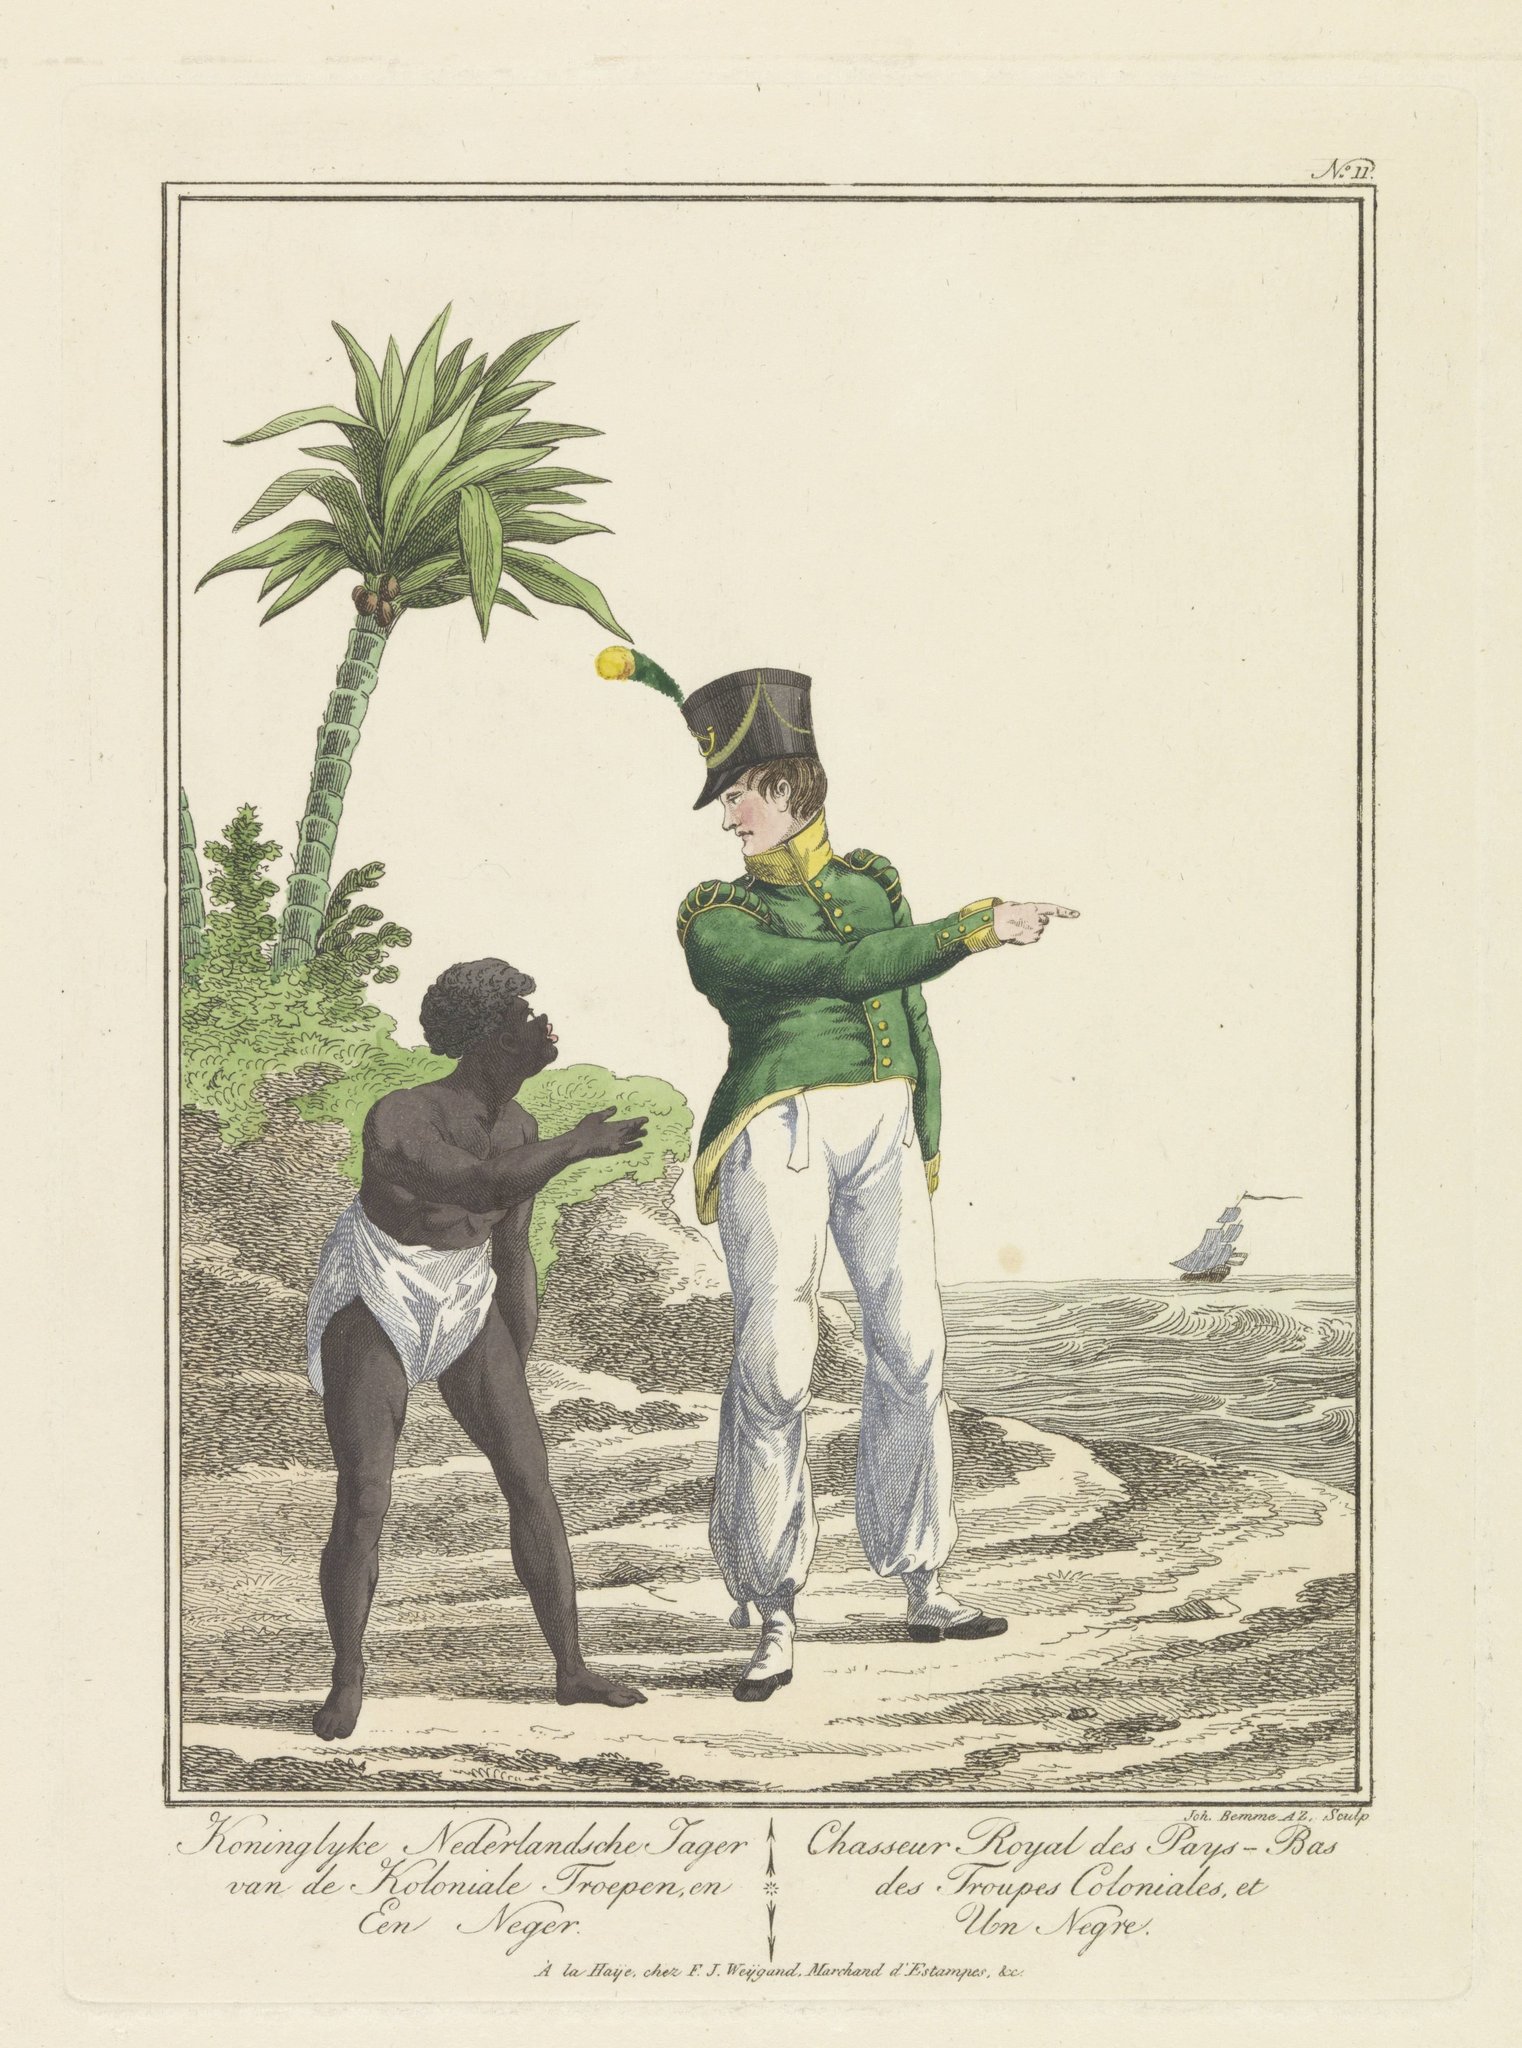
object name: print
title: Koloniale soldaat met inheemse man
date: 1800-1841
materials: paper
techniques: etching, hand coloring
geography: rotterdam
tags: africans, (military) uniforms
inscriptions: collector's mark: Lugt 2228